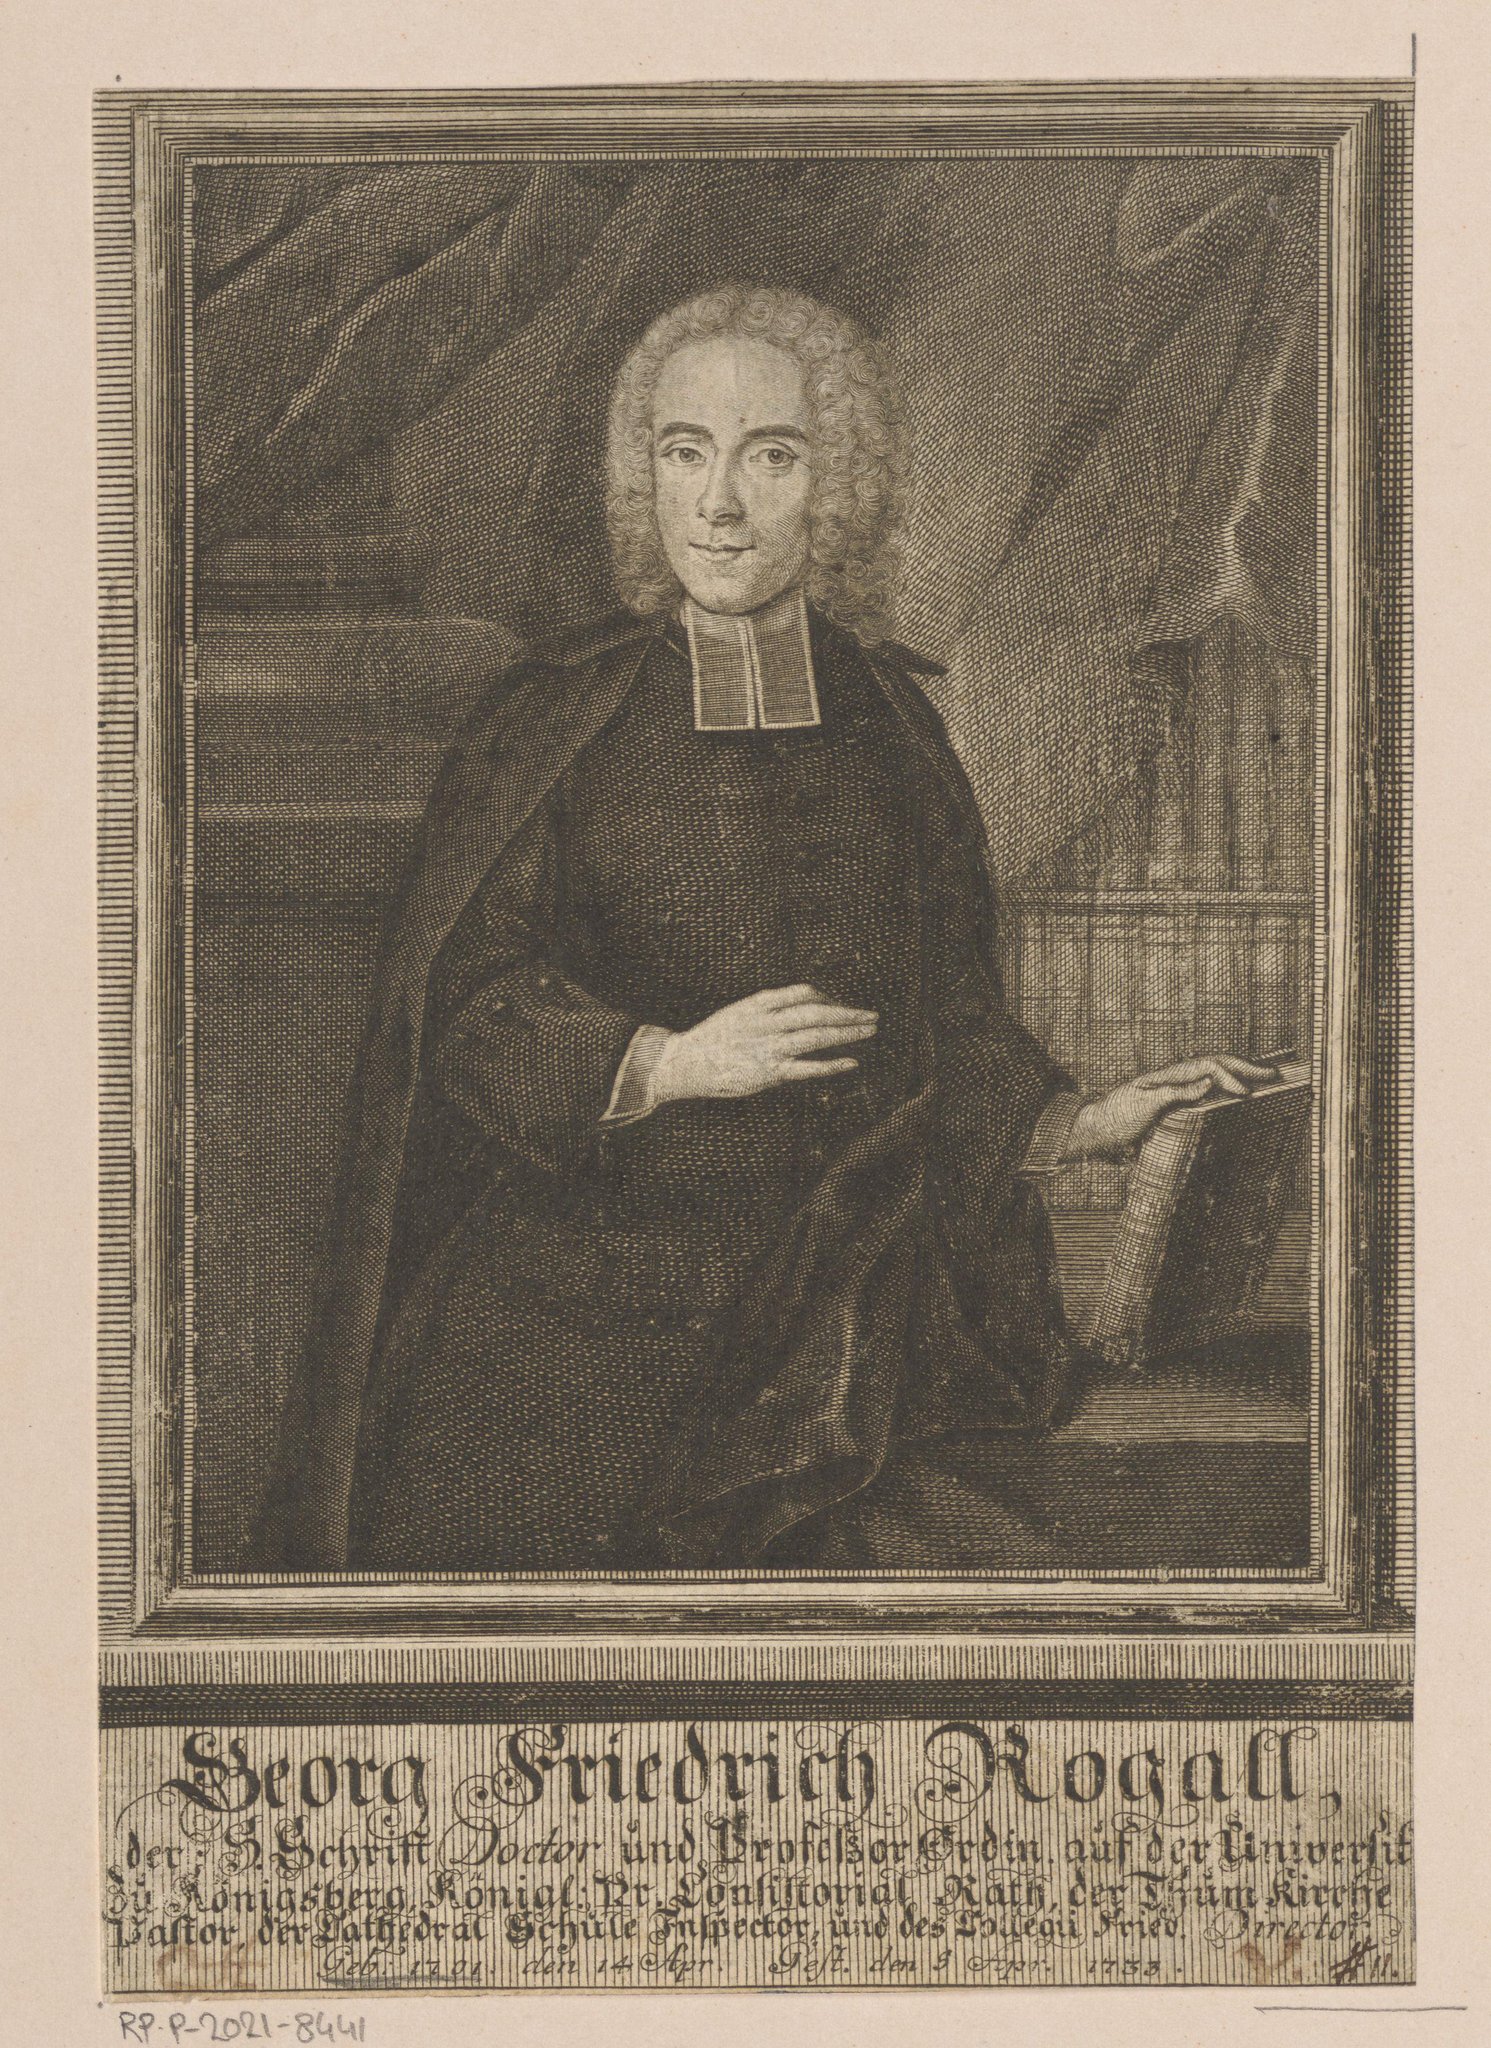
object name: print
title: Portret van Georg Friedrich Rogall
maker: christian fritzsch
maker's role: print maker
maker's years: 1695-1769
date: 1745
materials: paper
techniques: engraving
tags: theologian, historical persons, book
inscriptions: collector's mark: Lugt 2233